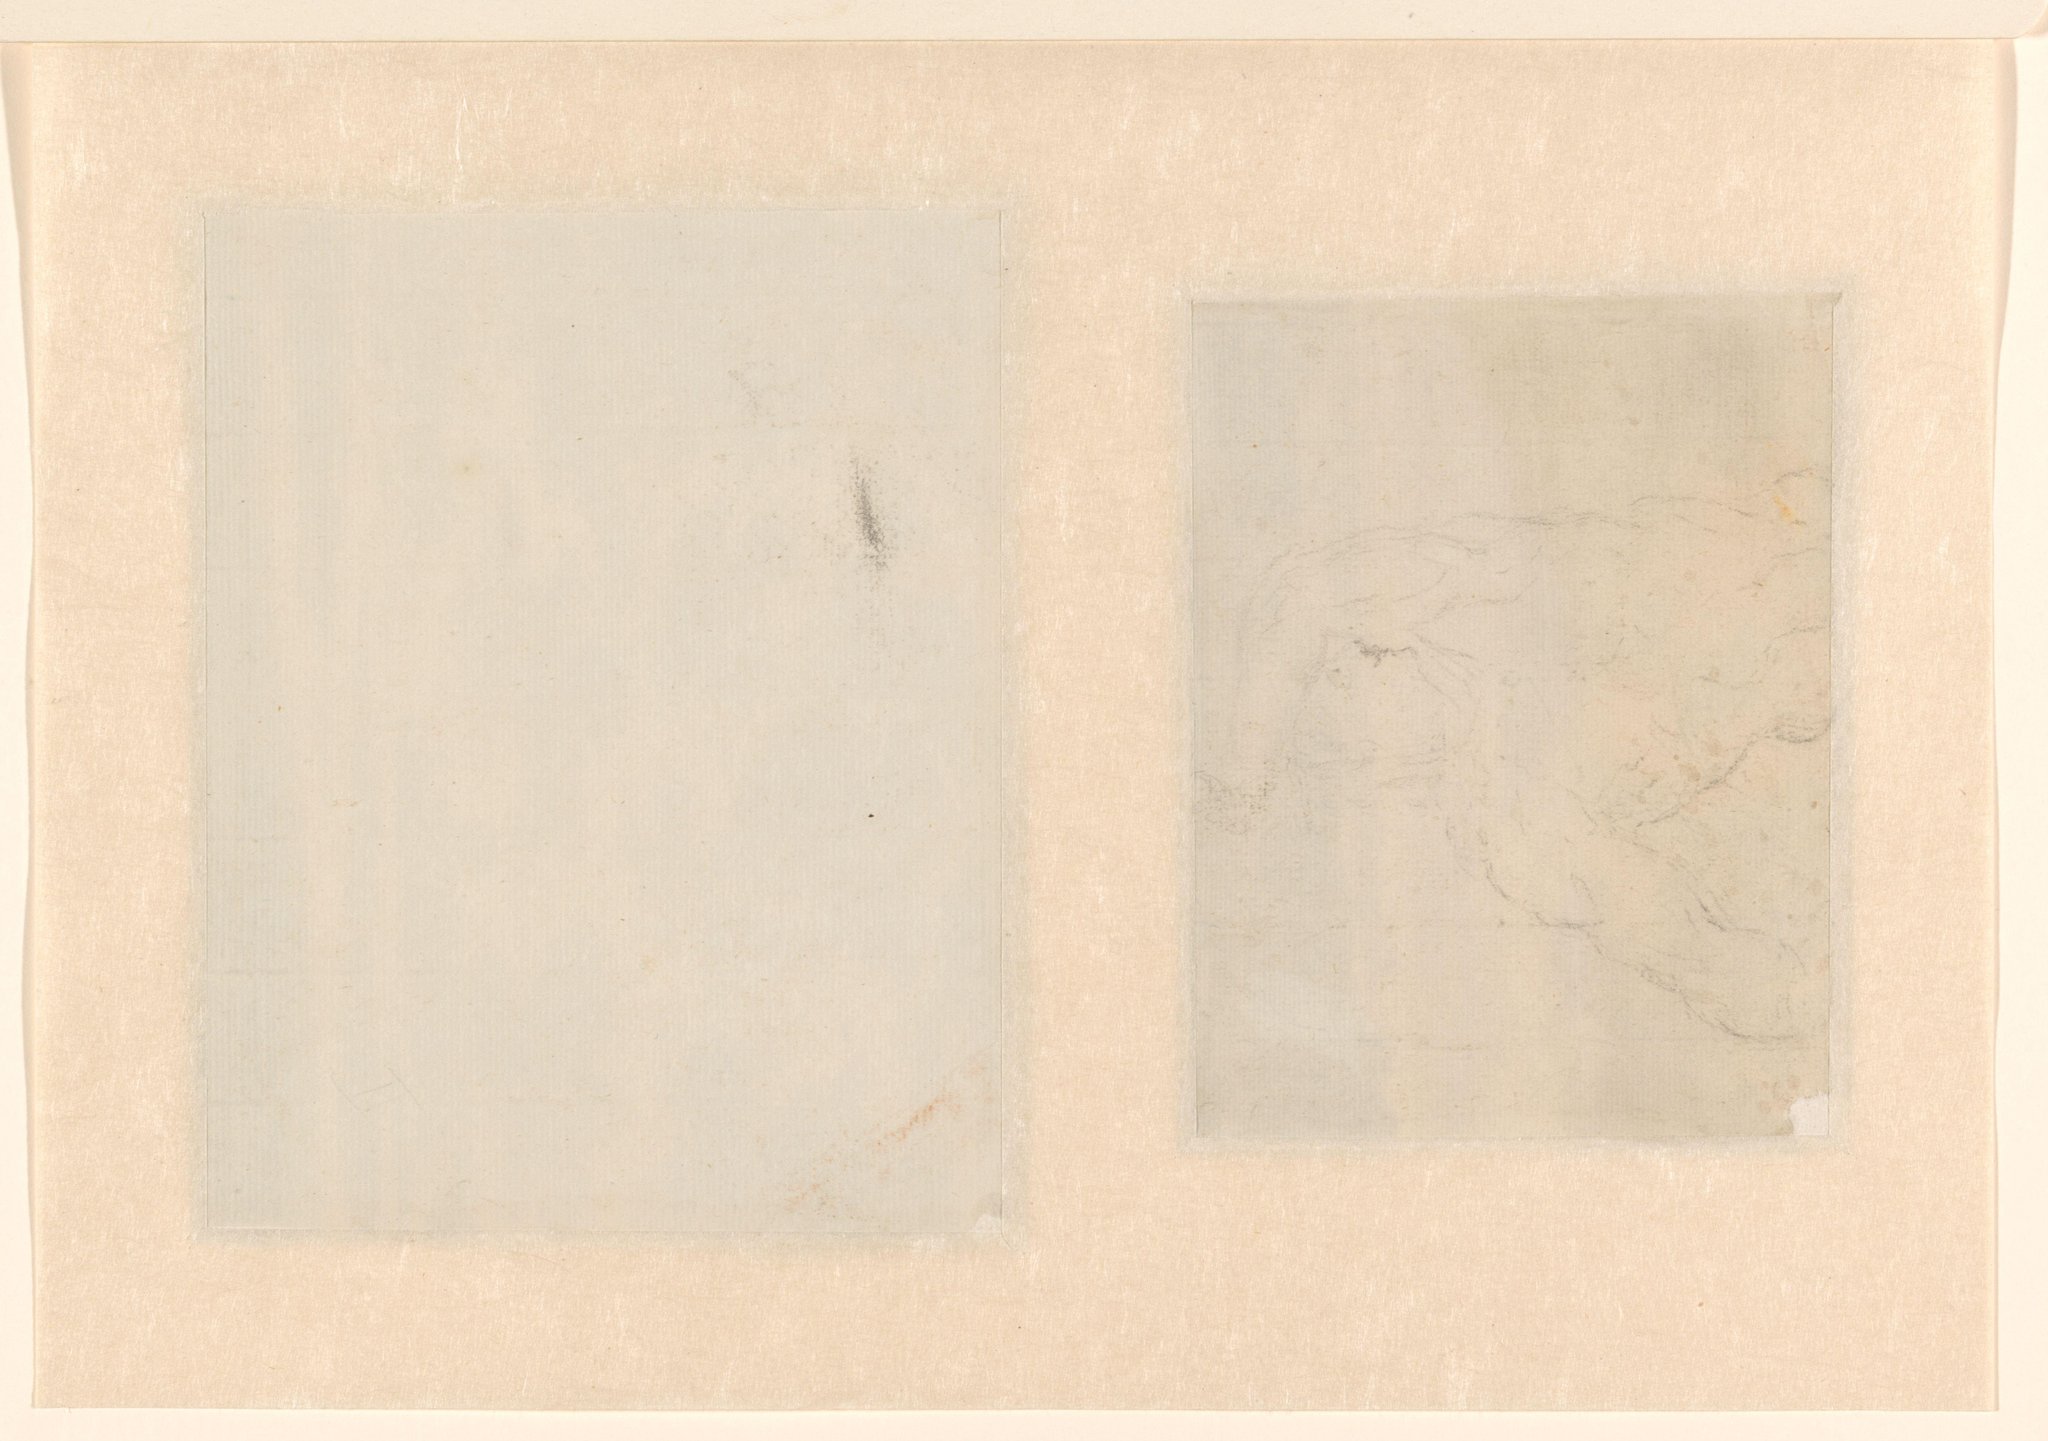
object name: drawing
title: Schets van het bovenlichaam van een gespierde man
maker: pieter idserts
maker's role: draughtsman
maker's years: 1698-1781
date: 1708-1781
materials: chalk, paper